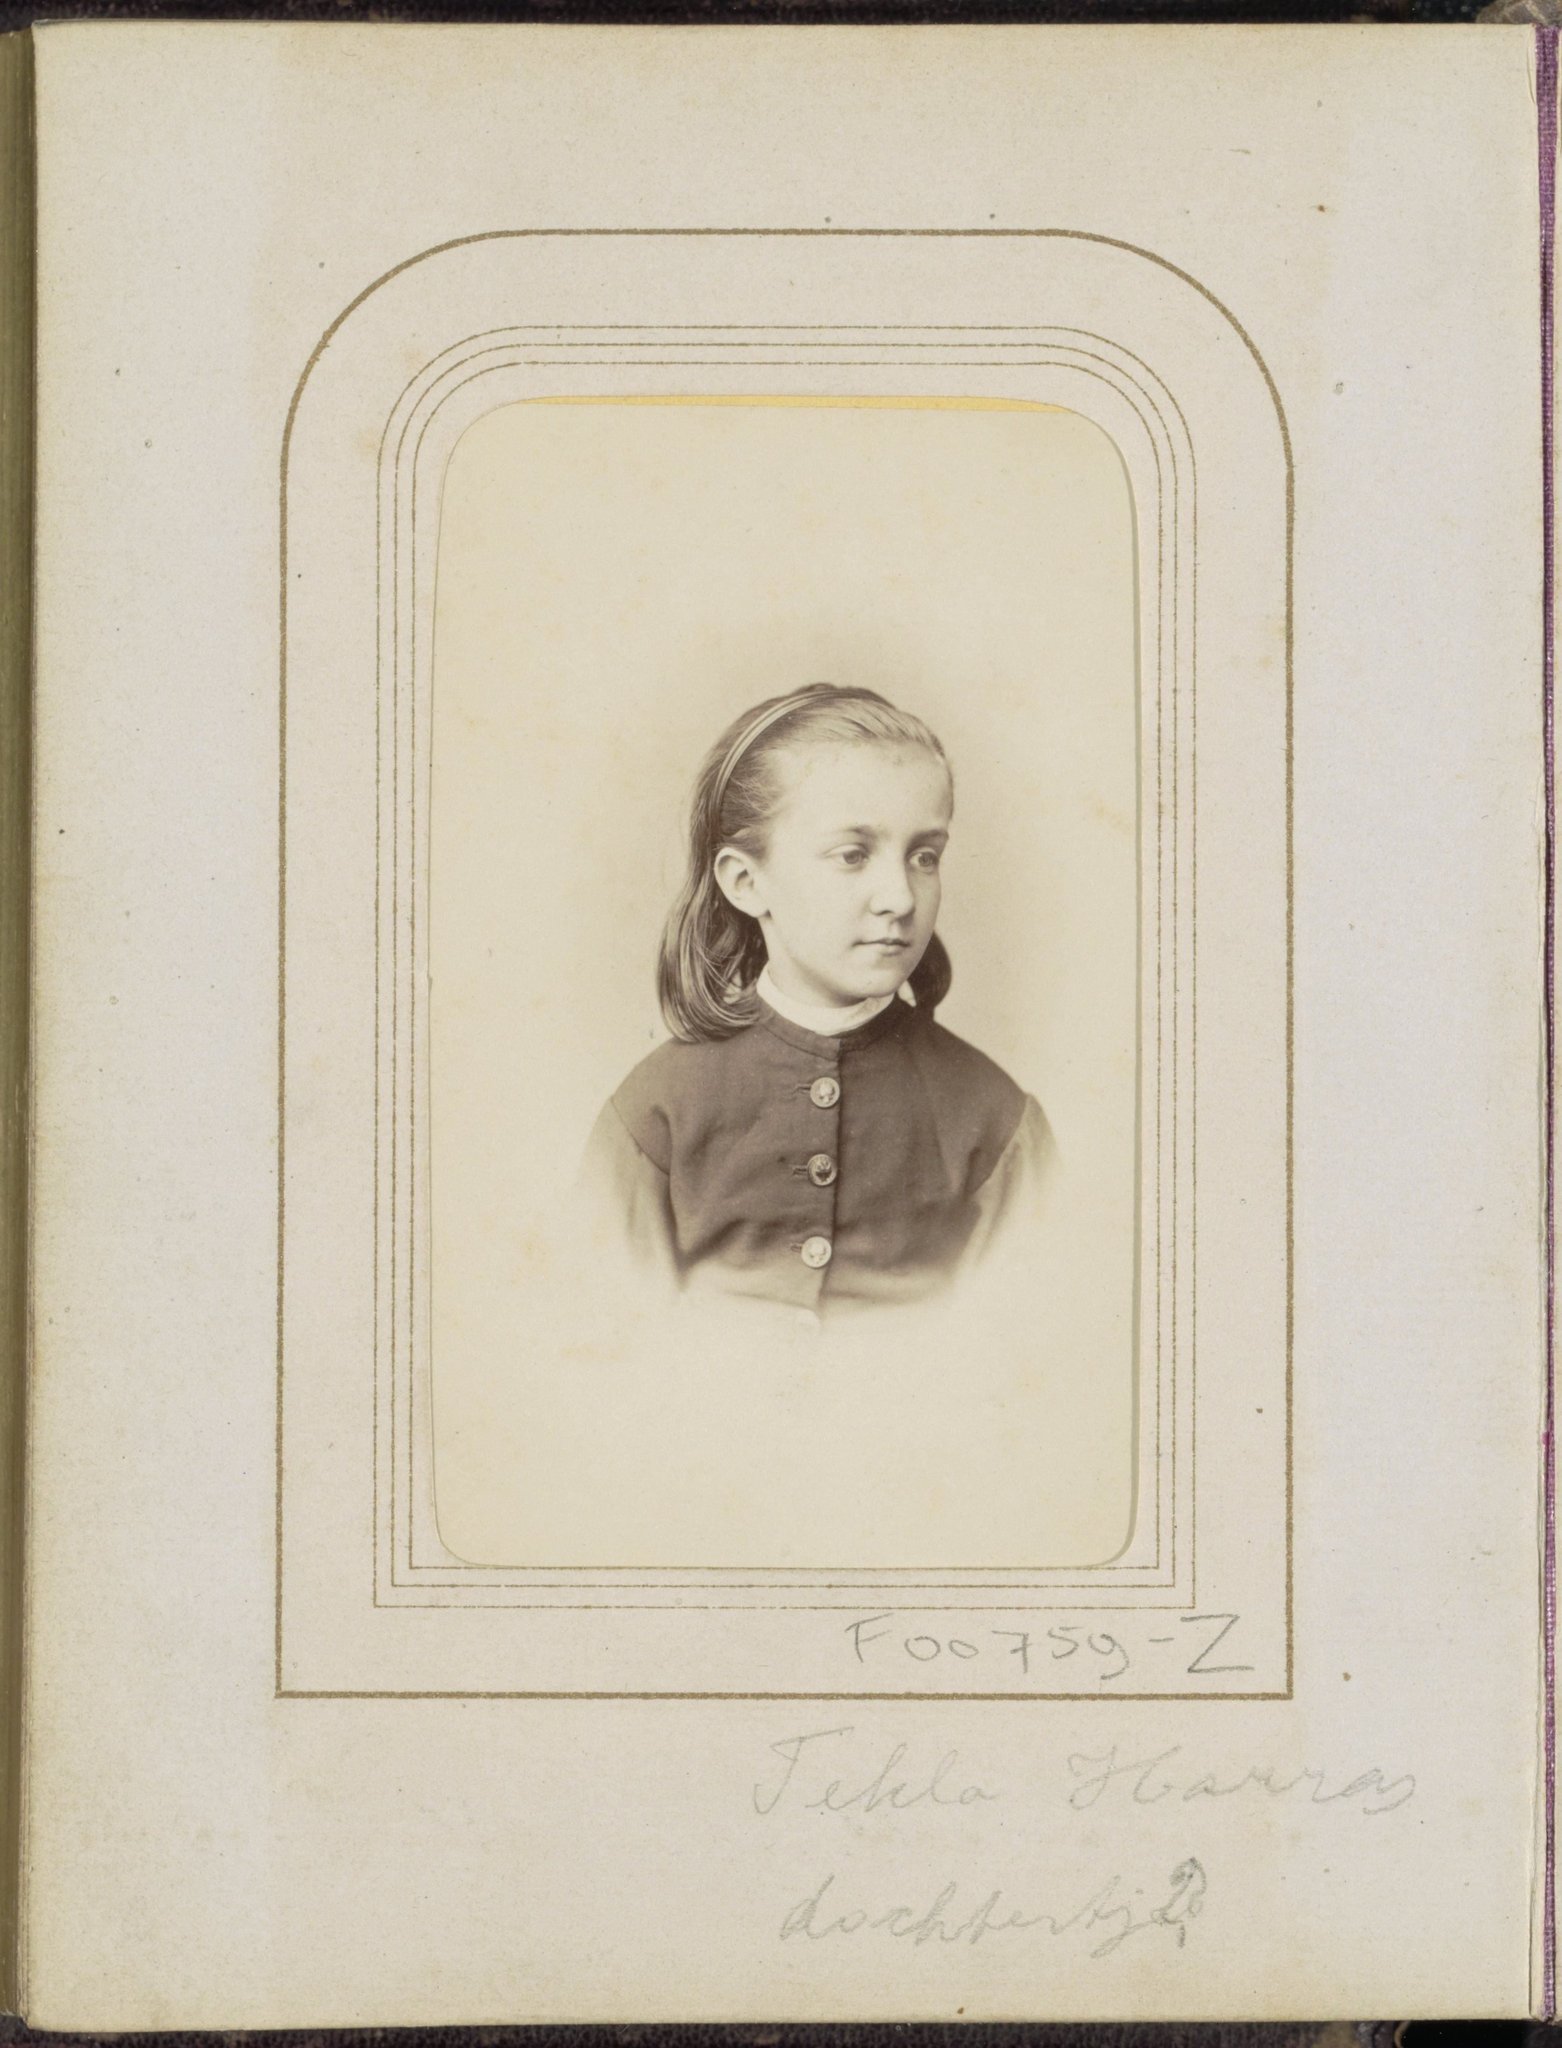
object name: carte de visite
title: Portret van een meisje aangeduid als Tekla Harras dochtertje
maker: n.a. dietz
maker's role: fotograaf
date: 1860-1870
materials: cardboard, paper, photographic support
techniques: albumen print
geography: munich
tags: historical persons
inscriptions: address: ‘München, Sendlingerthorplatz Nr. 6 a./O. (Kupferstecher)’, inscription: ‘Tekla Harras dochtertje[...]’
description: Onderdeel van Fotoalbum van een Nederlandse familie met 50 cartes-de-visite.